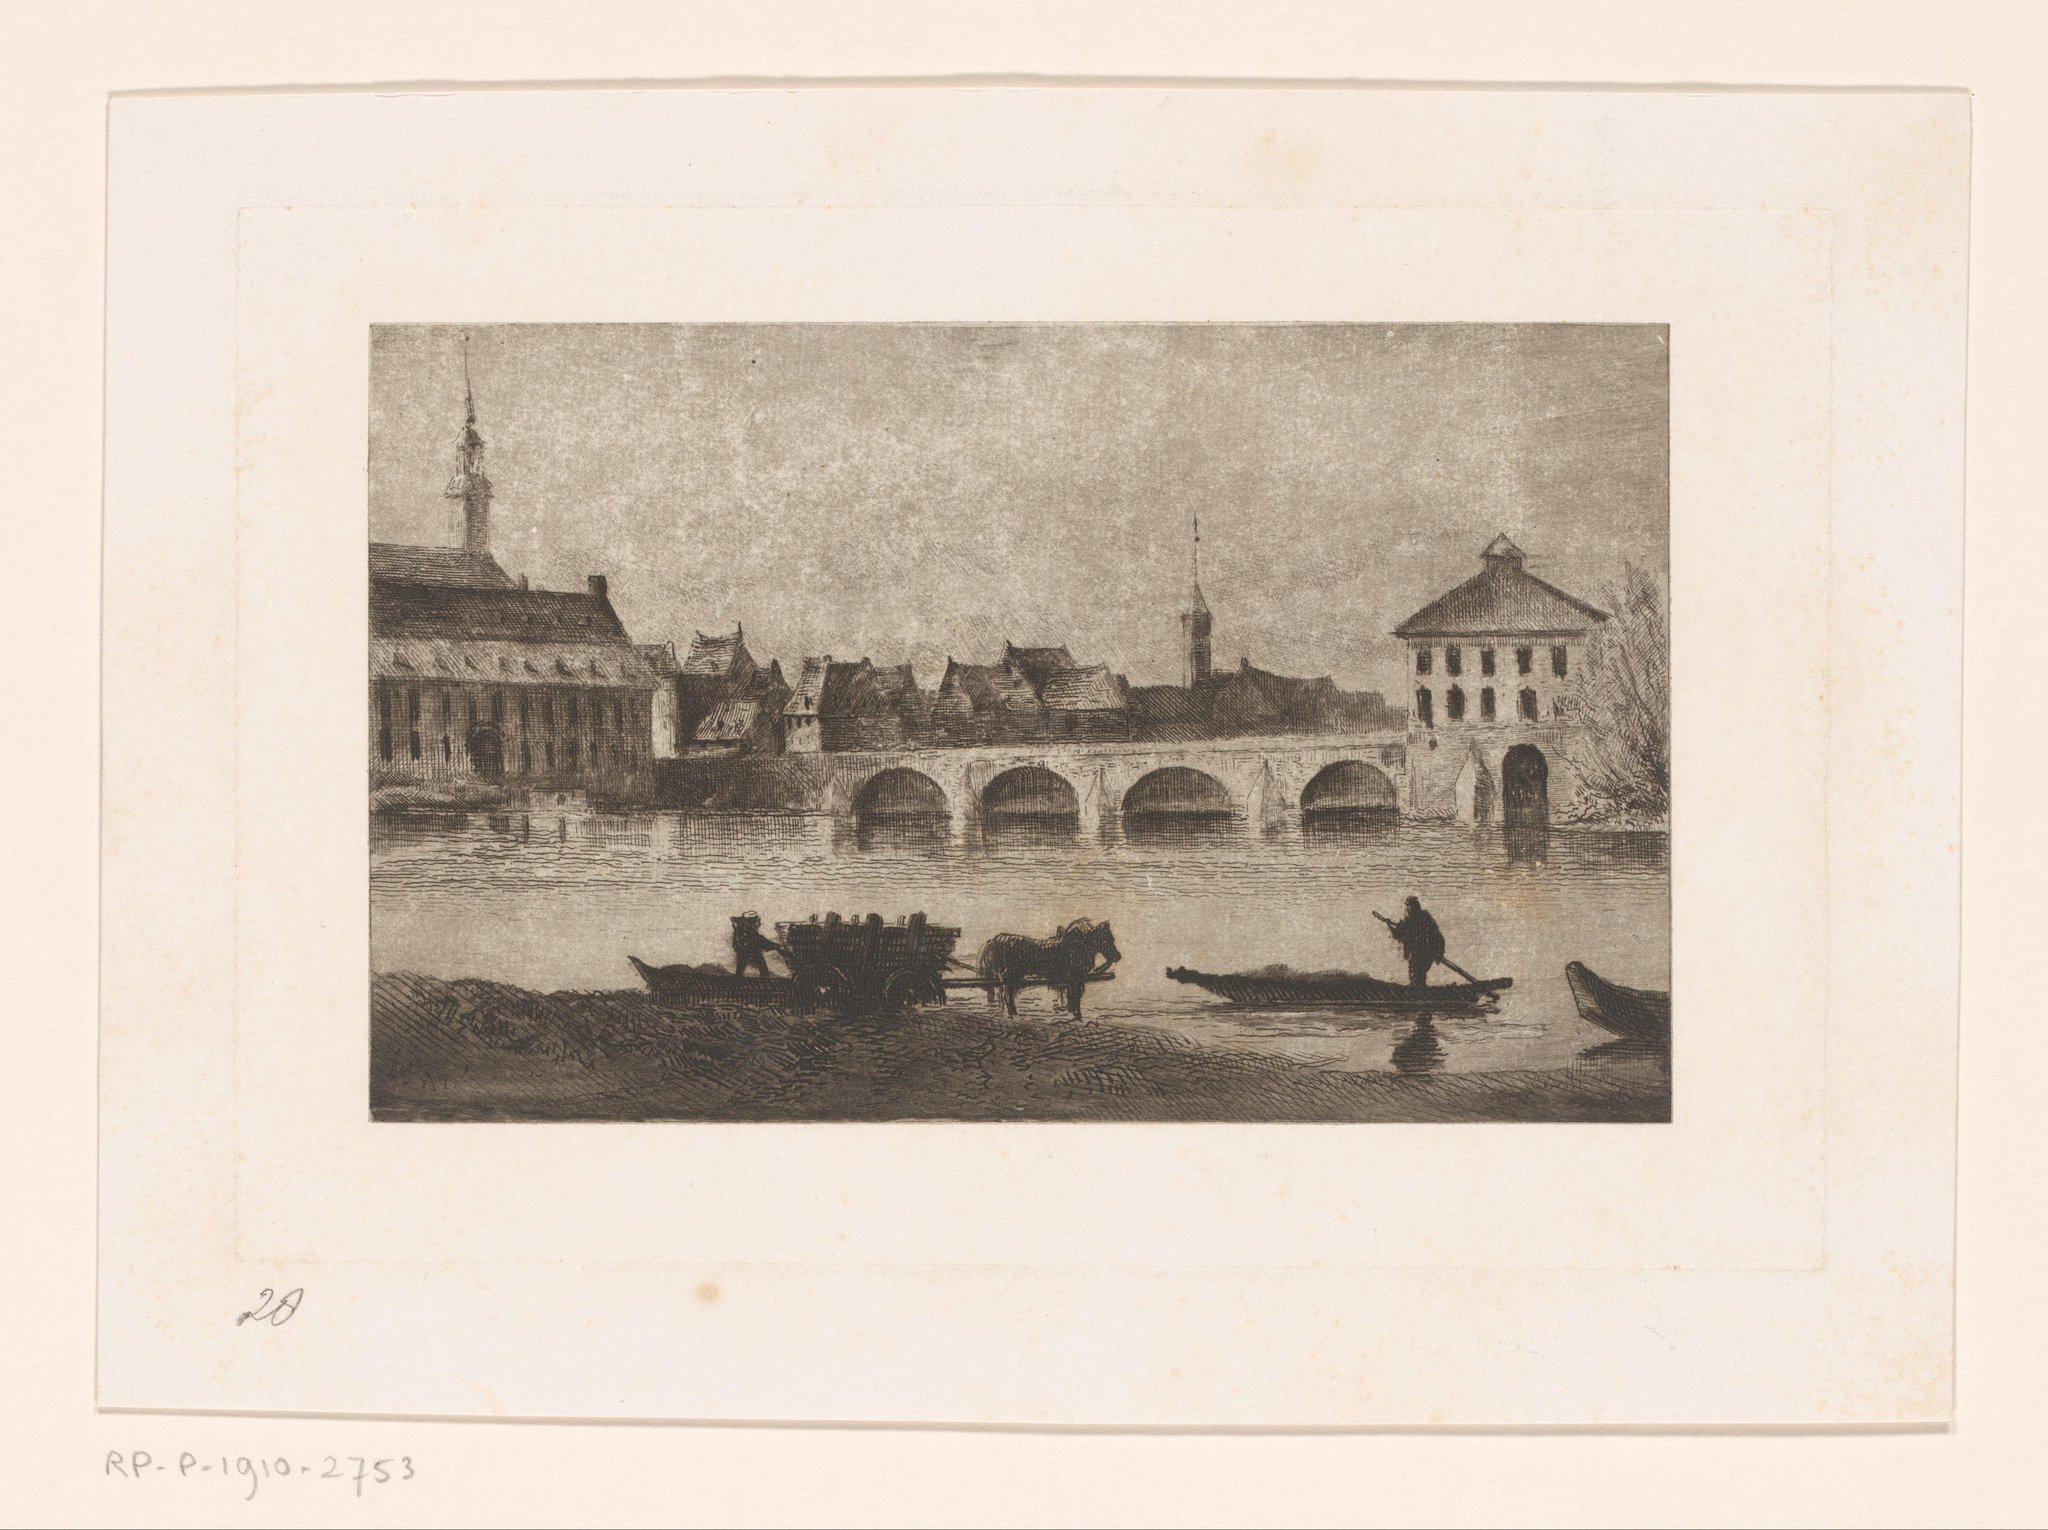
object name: print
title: Gezicht op de Alte Brücke in Frankfurt am Main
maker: carel nicolaas storm van s-gravesande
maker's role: draughtsman, print maker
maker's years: 1841-1924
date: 1872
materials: paper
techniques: etching, intaglio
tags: bridge in city across river, canal, etc.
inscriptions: collector's mark: Lugt 2228, inscription: ‘frankfurt am main’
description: Stadsgezicht met brug. Op de voorgrond een paard-en-wagen en twee gondels in de rivier.